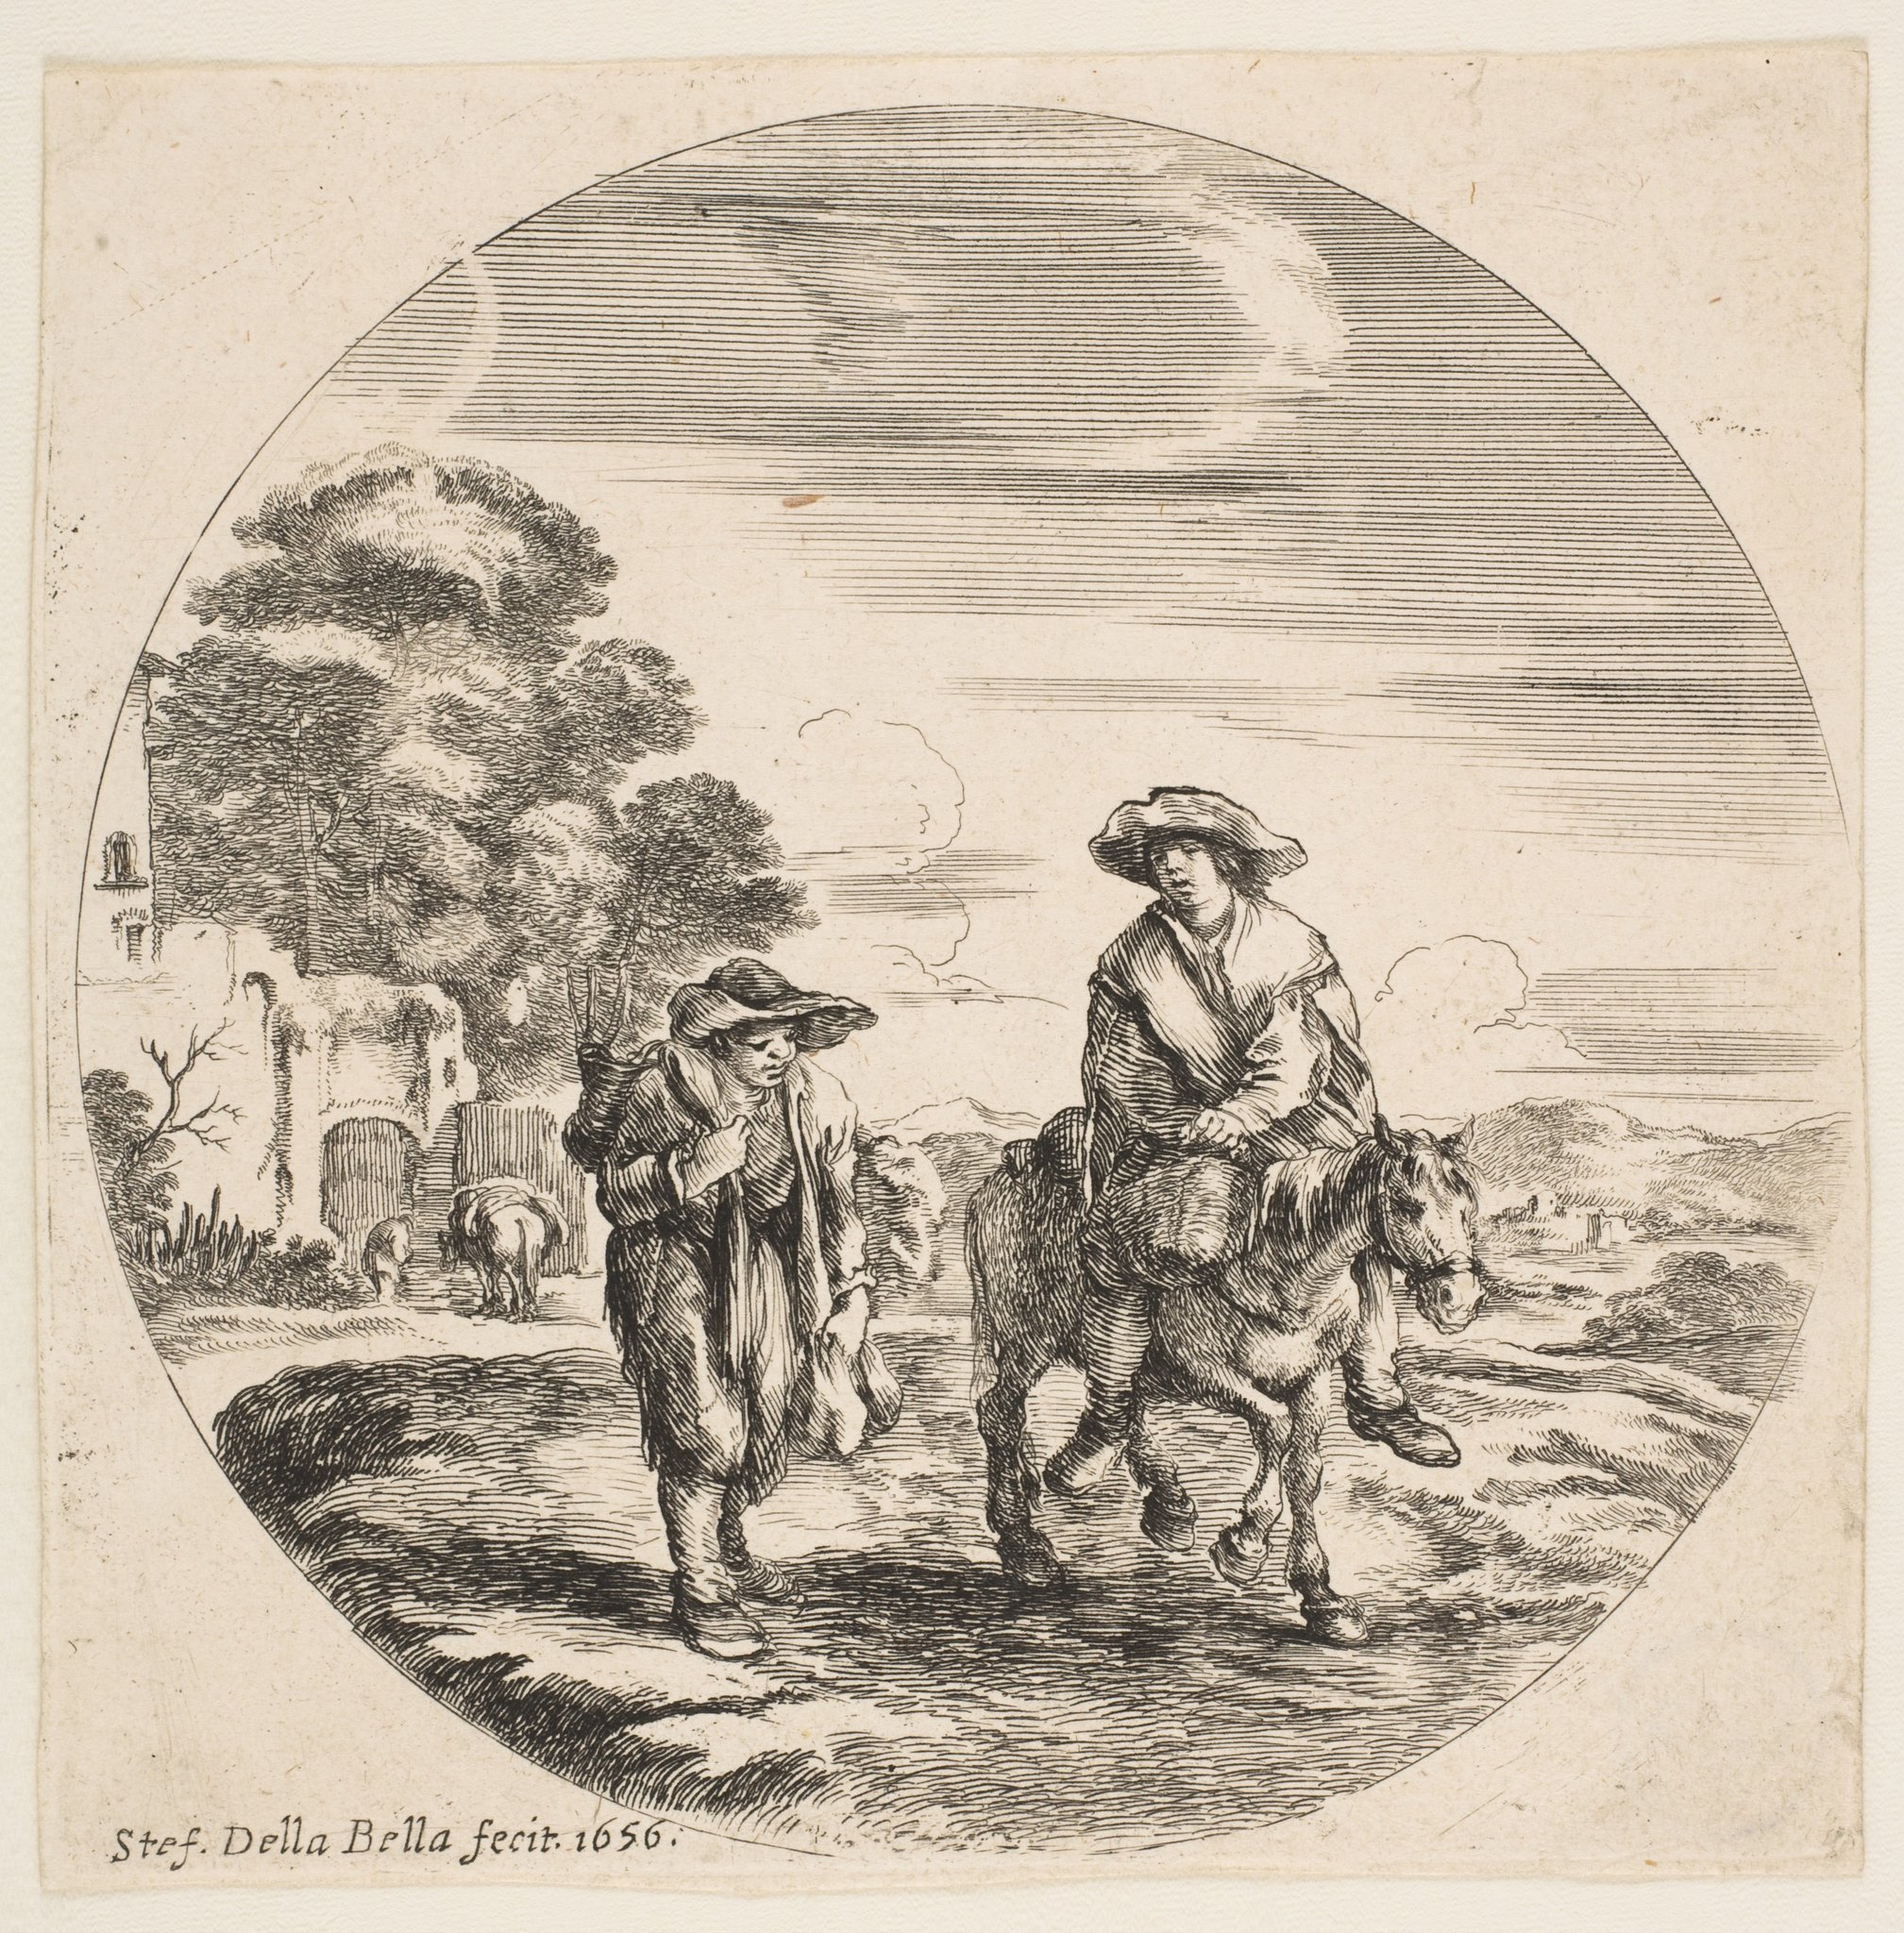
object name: print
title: Landscape with Two Peasants, One Riding a Horse, from "Landscapes and seaports" (Paysages et ports de mer, dans des ronds)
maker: stefano della bella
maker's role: artist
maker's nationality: italian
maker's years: 1610-1664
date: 1656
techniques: etching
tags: men,horses,landscapes